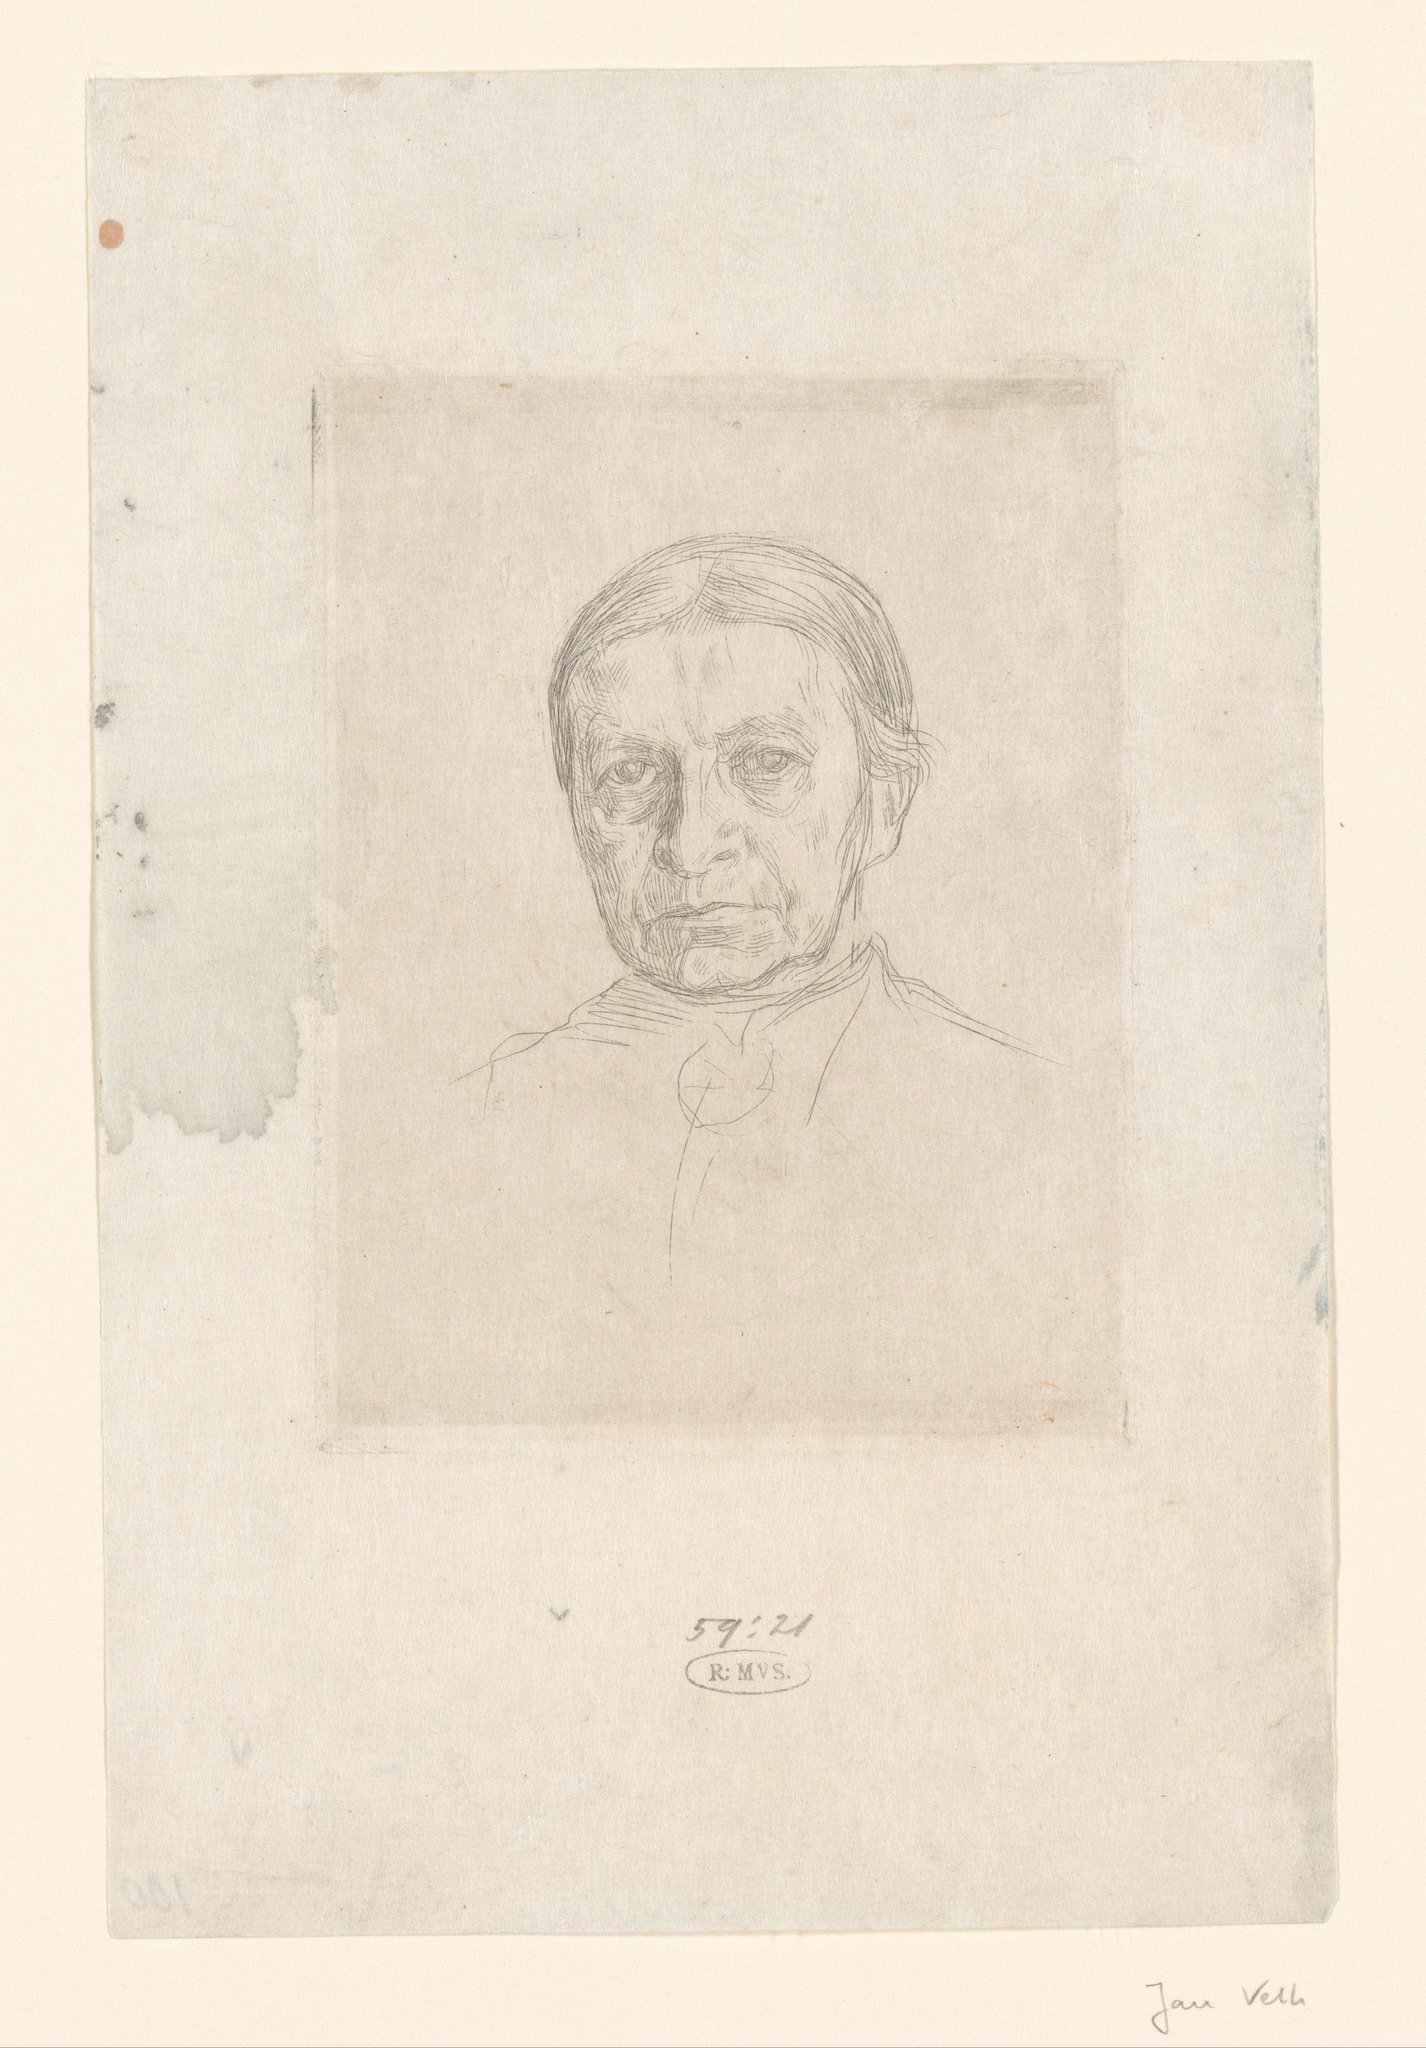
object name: print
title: Portret van mevrouw Anna Cornelia Veth-Giltay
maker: jan veth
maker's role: designer, draughtsman, painter, print maker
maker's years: 1864-1925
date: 1887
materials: paper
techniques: etching, intaglio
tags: historical persons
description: Geportretteerde is de moeder van de kunstenaar.